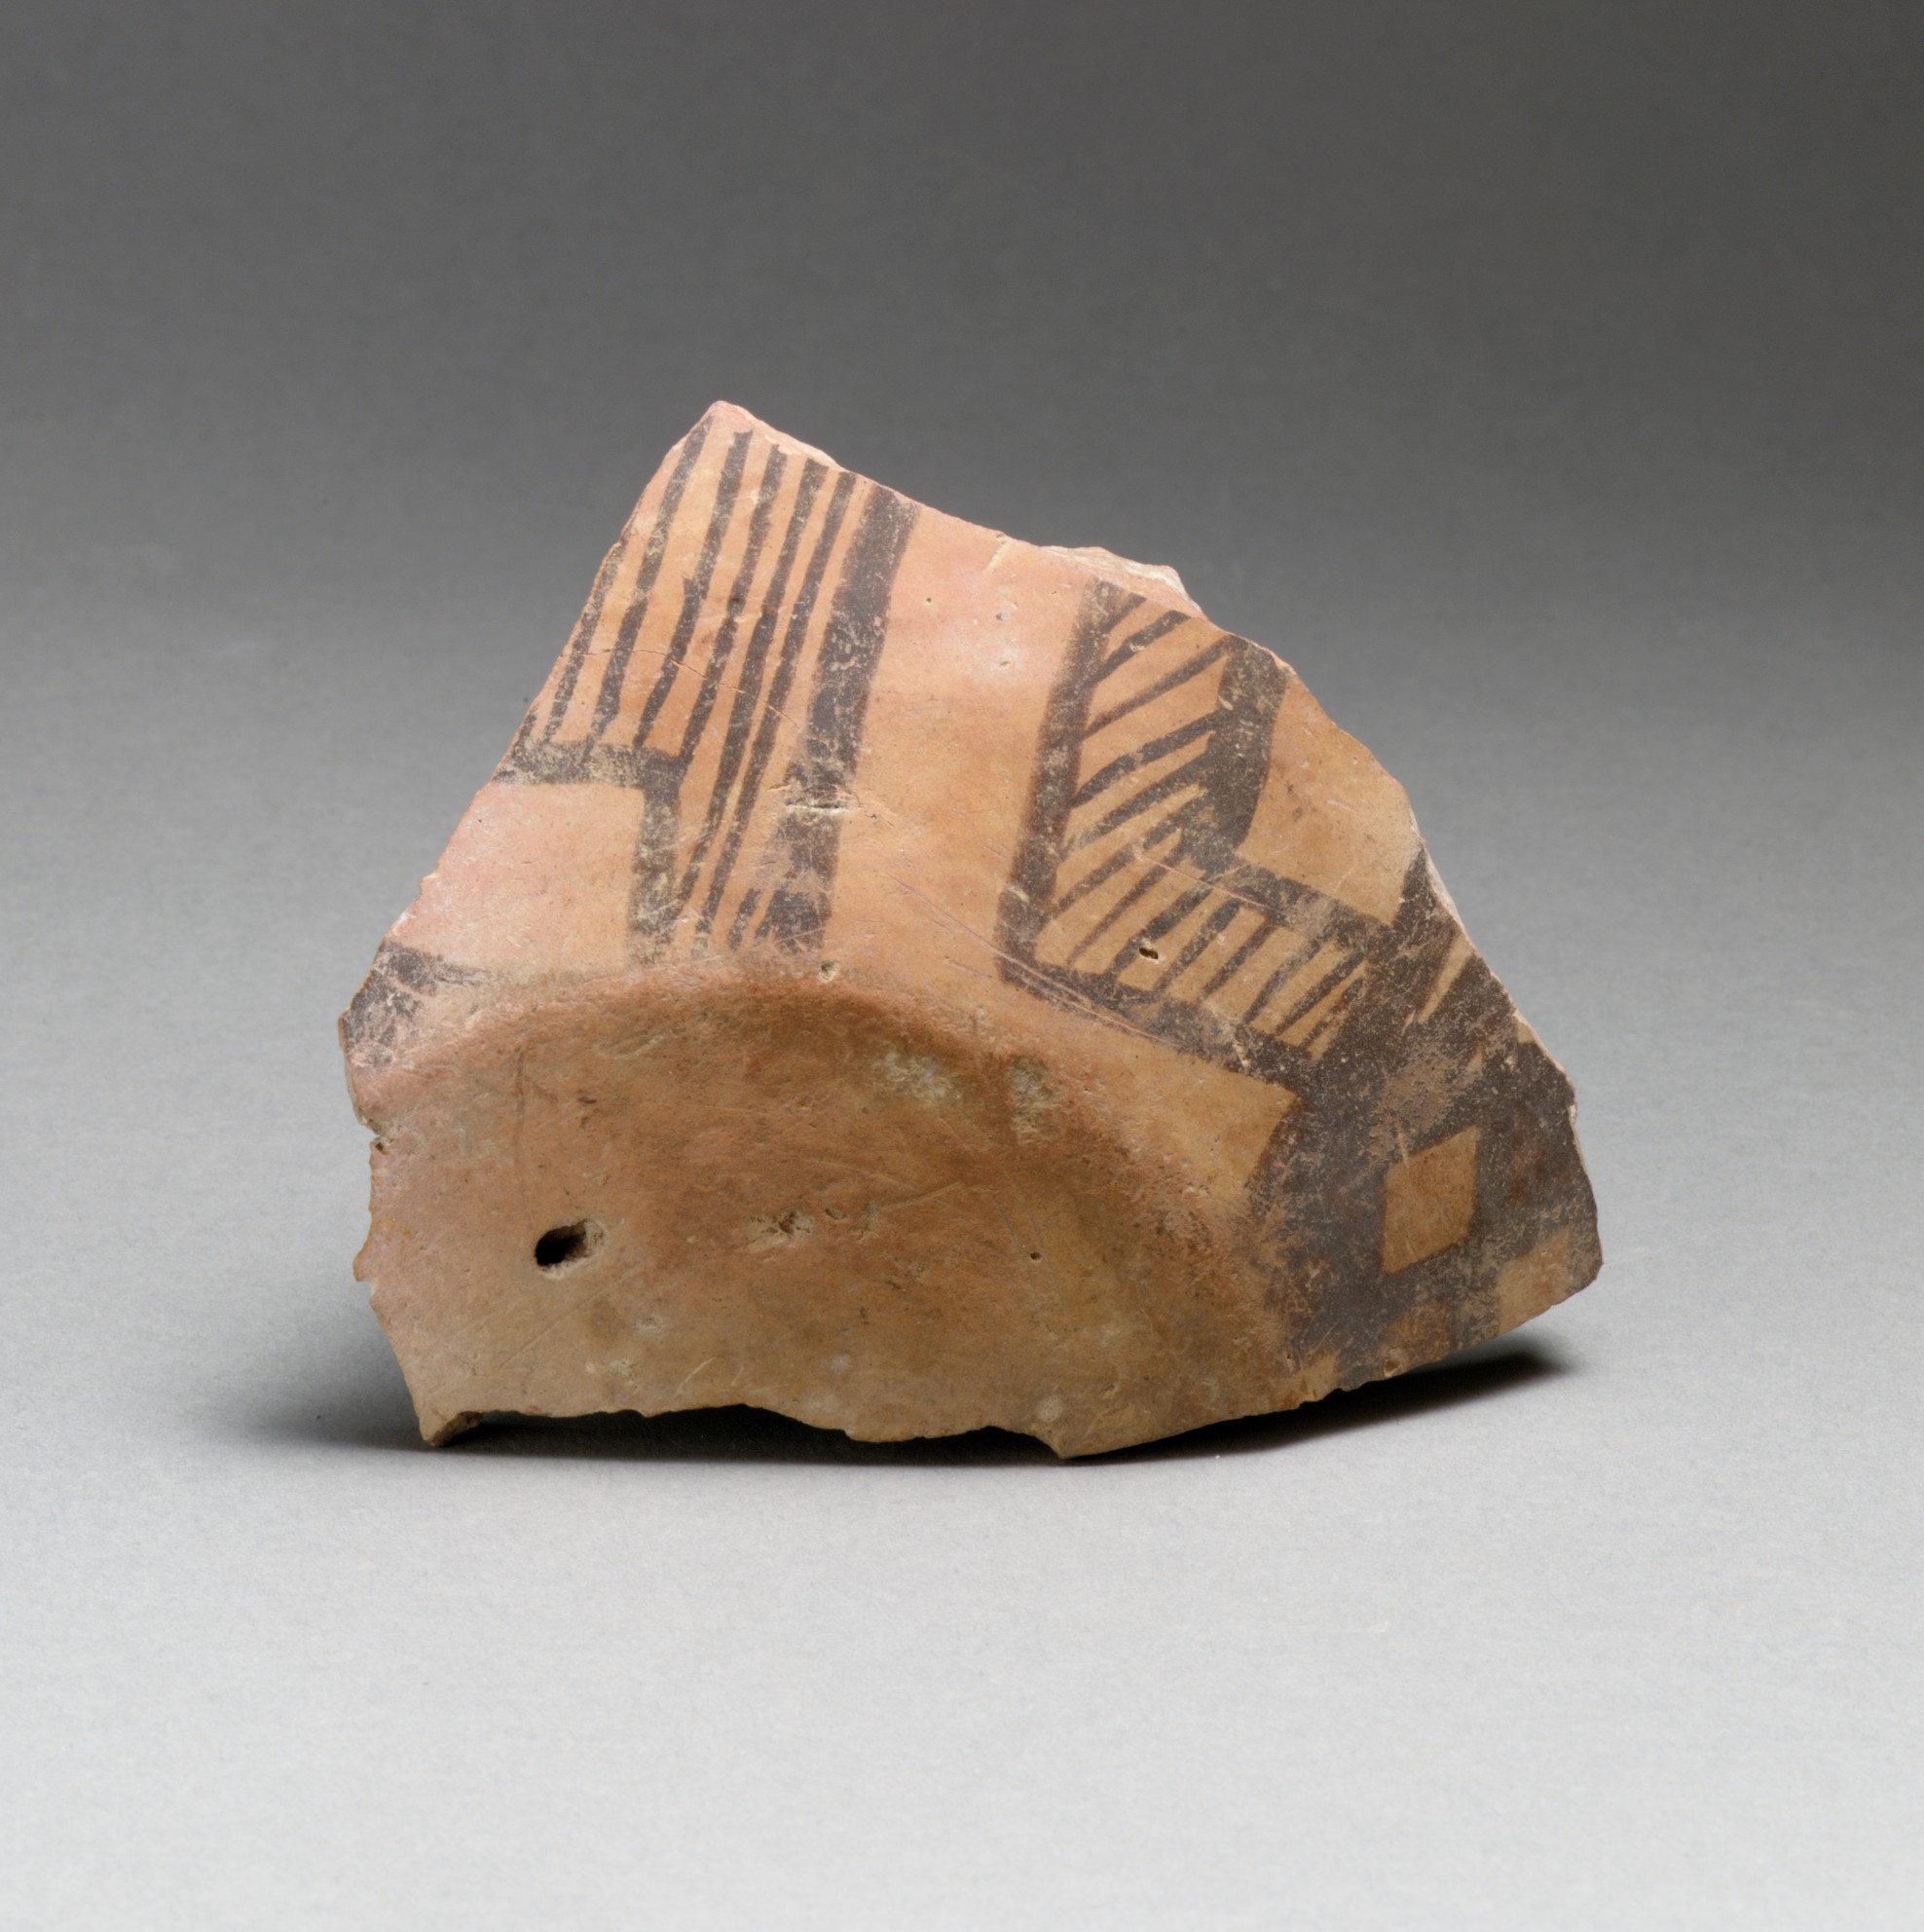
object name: vase fragment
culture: neolithic, thessaly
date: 4000-3000 BCE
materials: terracotta